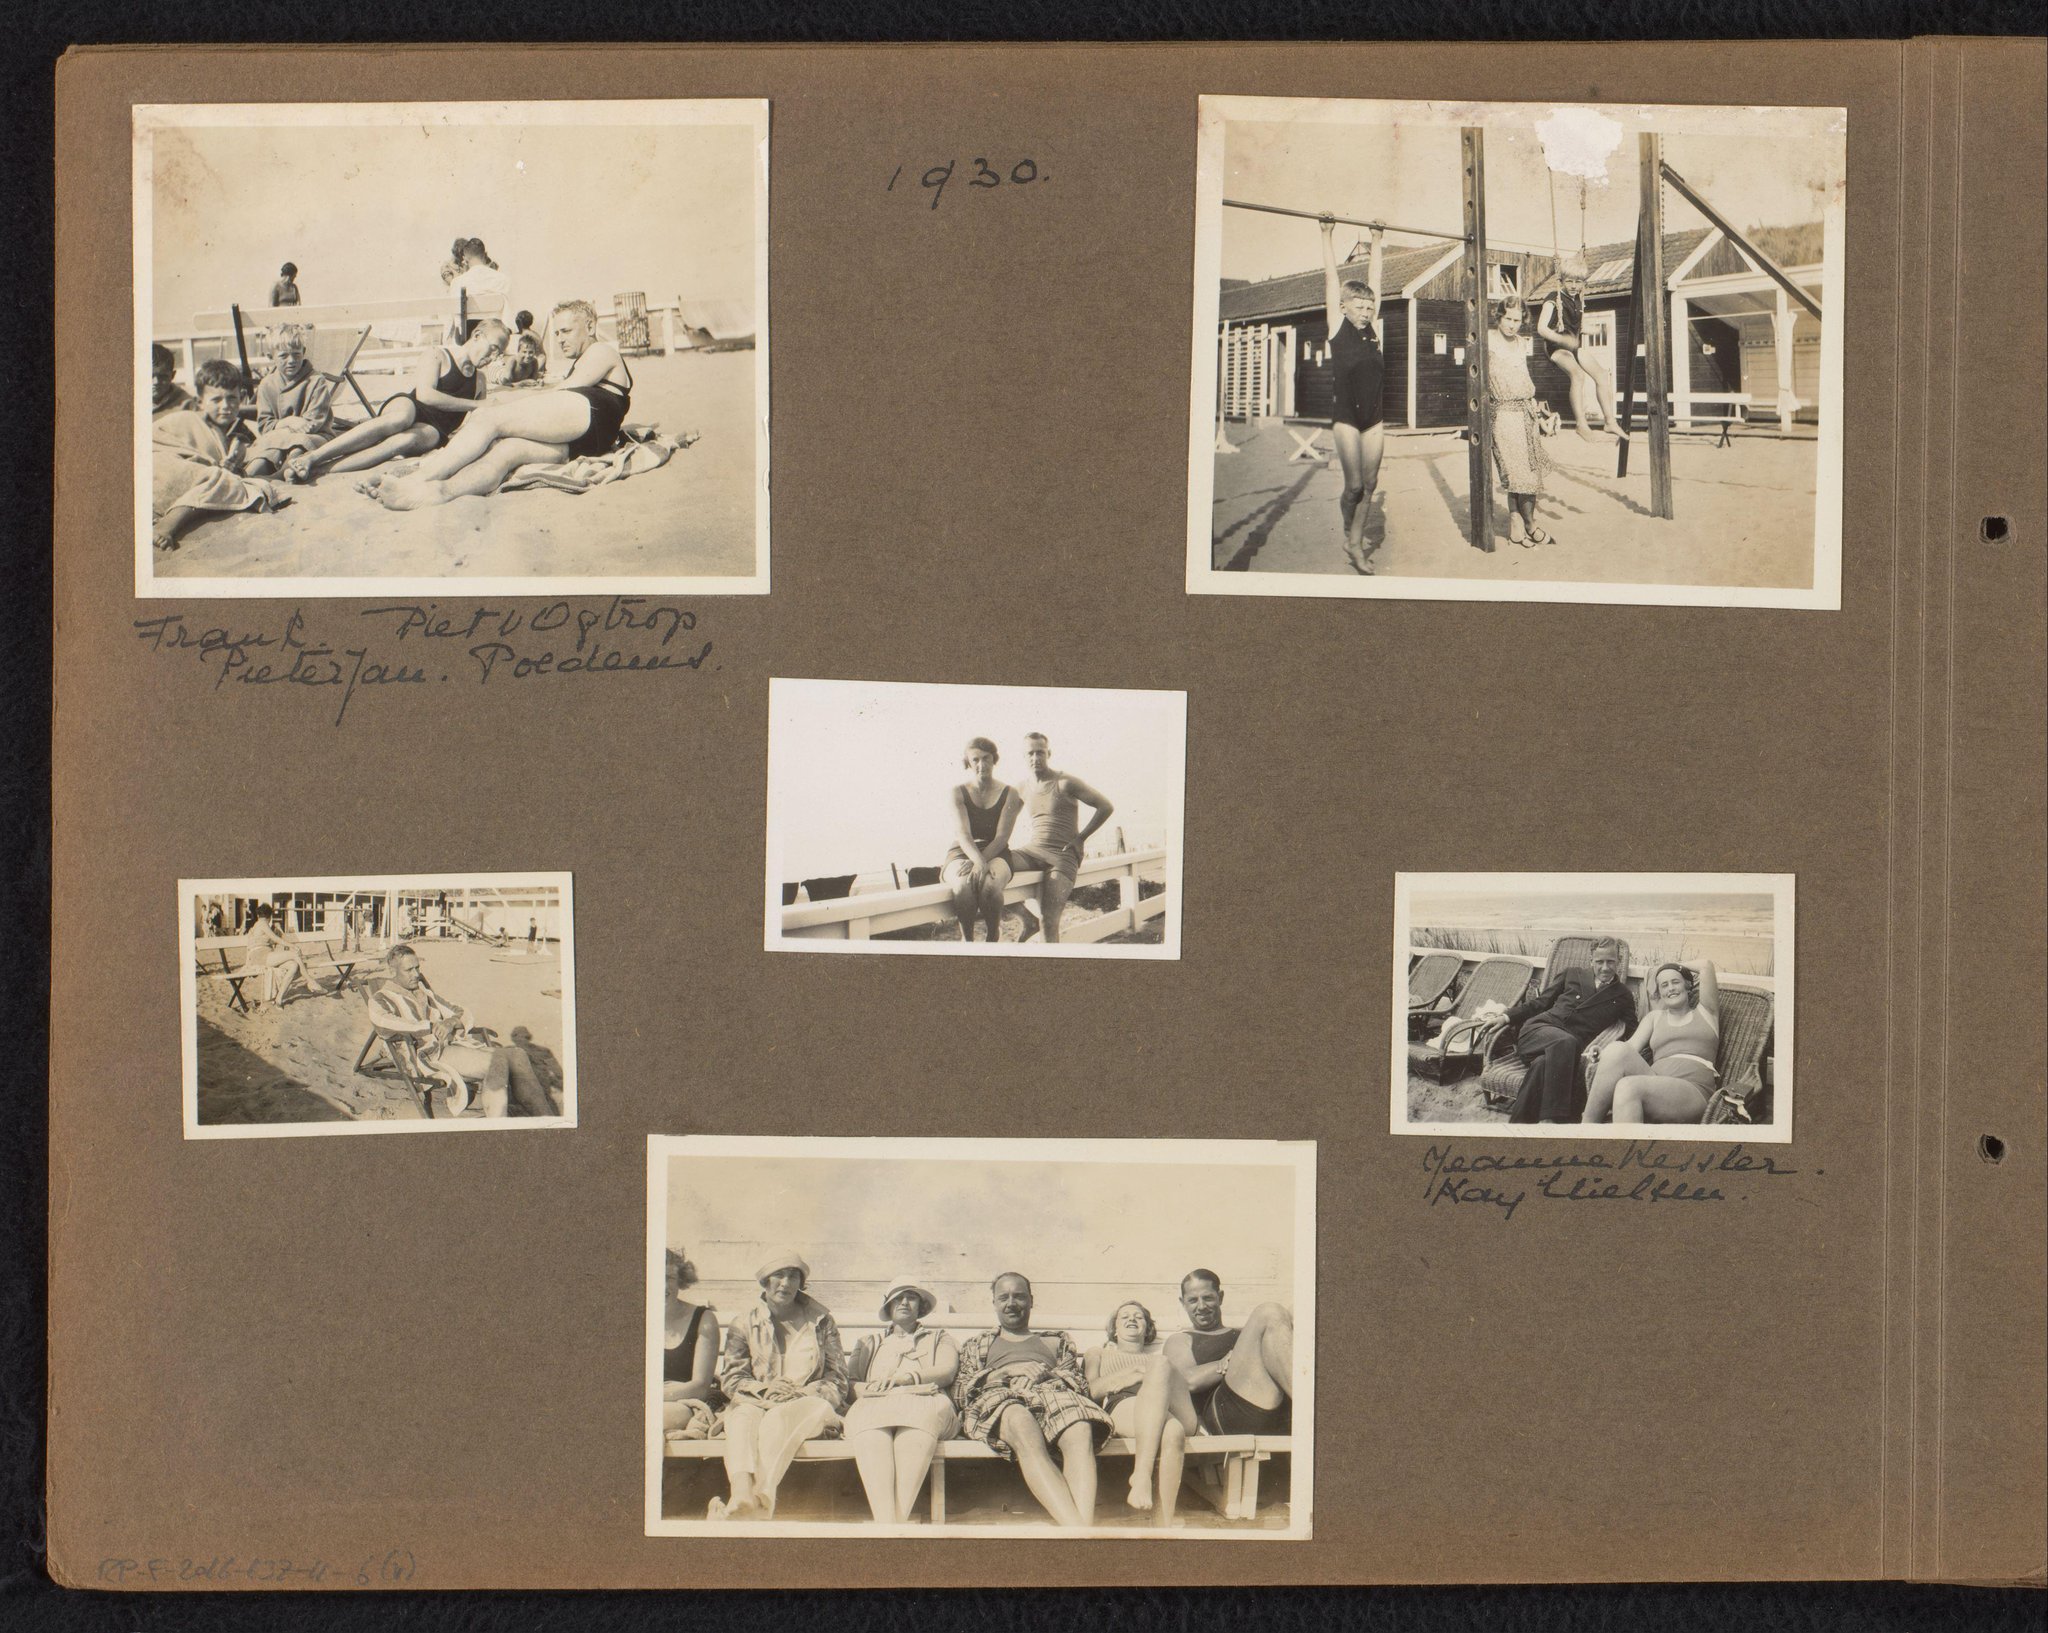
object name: album leaf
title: Loentje Furnée met vrienden en kinderen op het strand van Noordwijk, met Piet van Ostrop, Jeanne Kessler en Kay Liefter [?]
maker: carolina frederika onnen (lien/loen)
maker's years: 1896-1983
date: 1930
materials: paper, cardboard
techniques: gelatin silver print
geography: noordwijk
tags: amsterdam, carolina frederika onnen (lien/loen), beach (as place of recreation)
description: Deze foto's zijn onderdeel van een album.